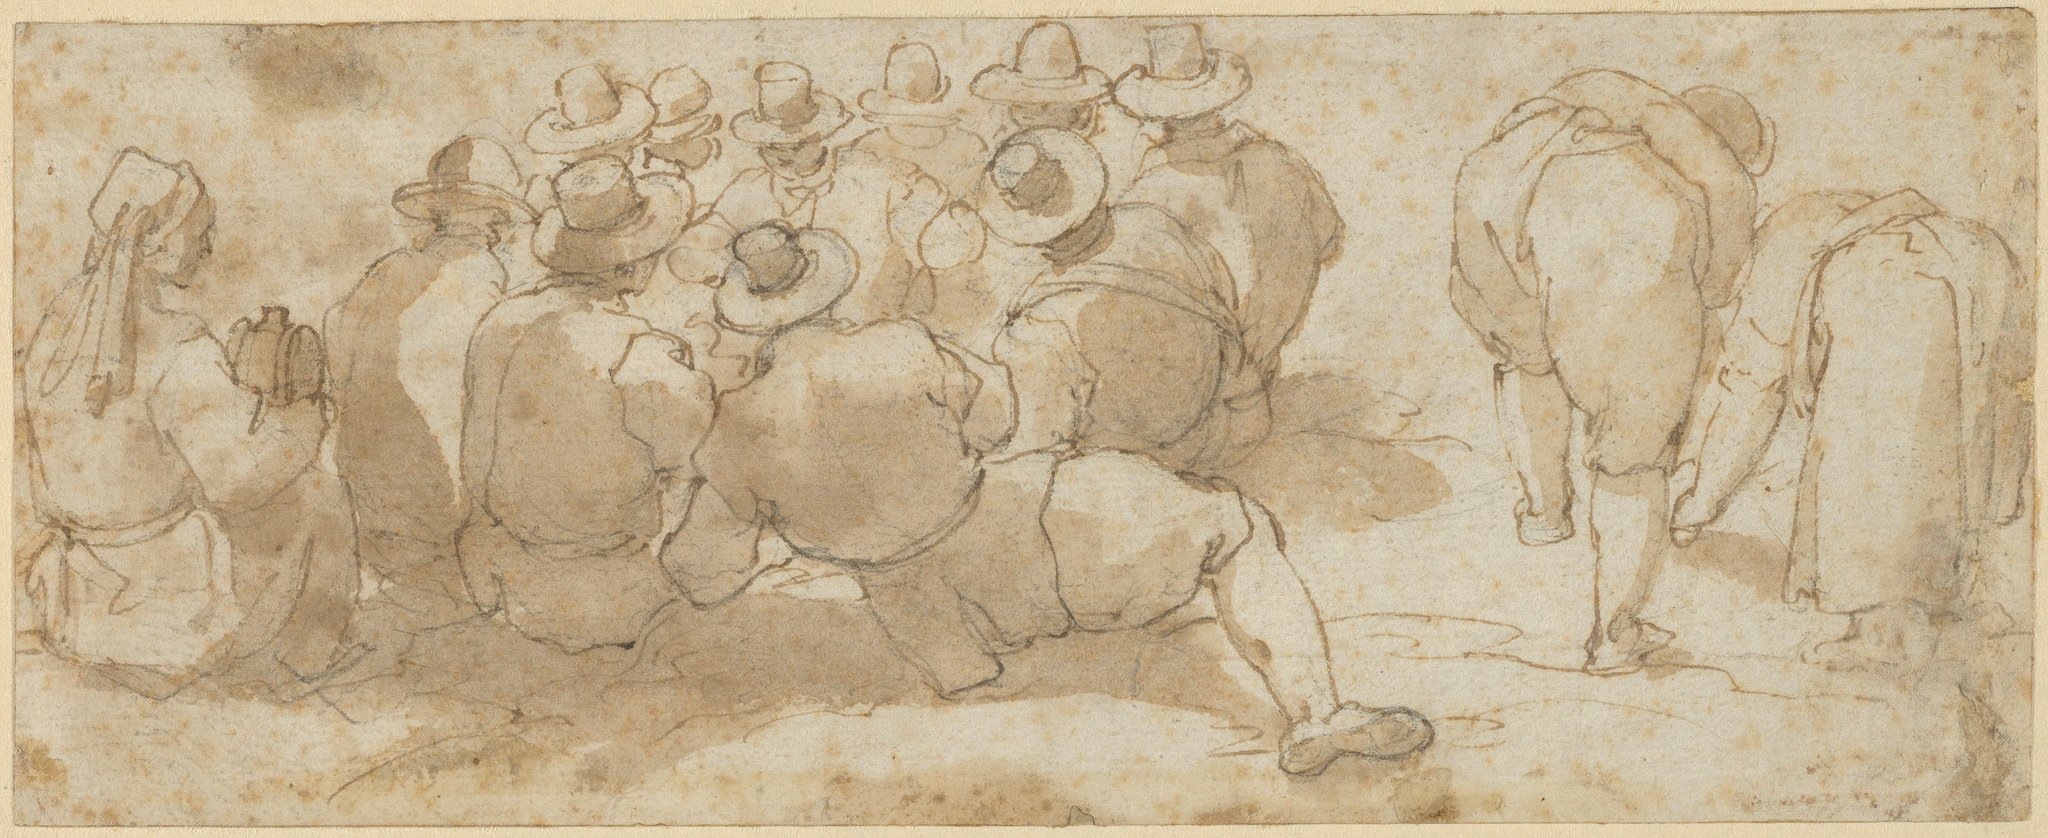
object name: drawing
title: Group of Laborers in a Field (recto); Angel Appearing to a Kneeling Saint (verso)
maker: giovanni battista maganza the elder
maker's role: artist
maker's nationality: italian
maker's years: 1513-1586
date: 1530-1586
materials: chalk, ink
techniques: brush, pen, wash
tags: men,saints